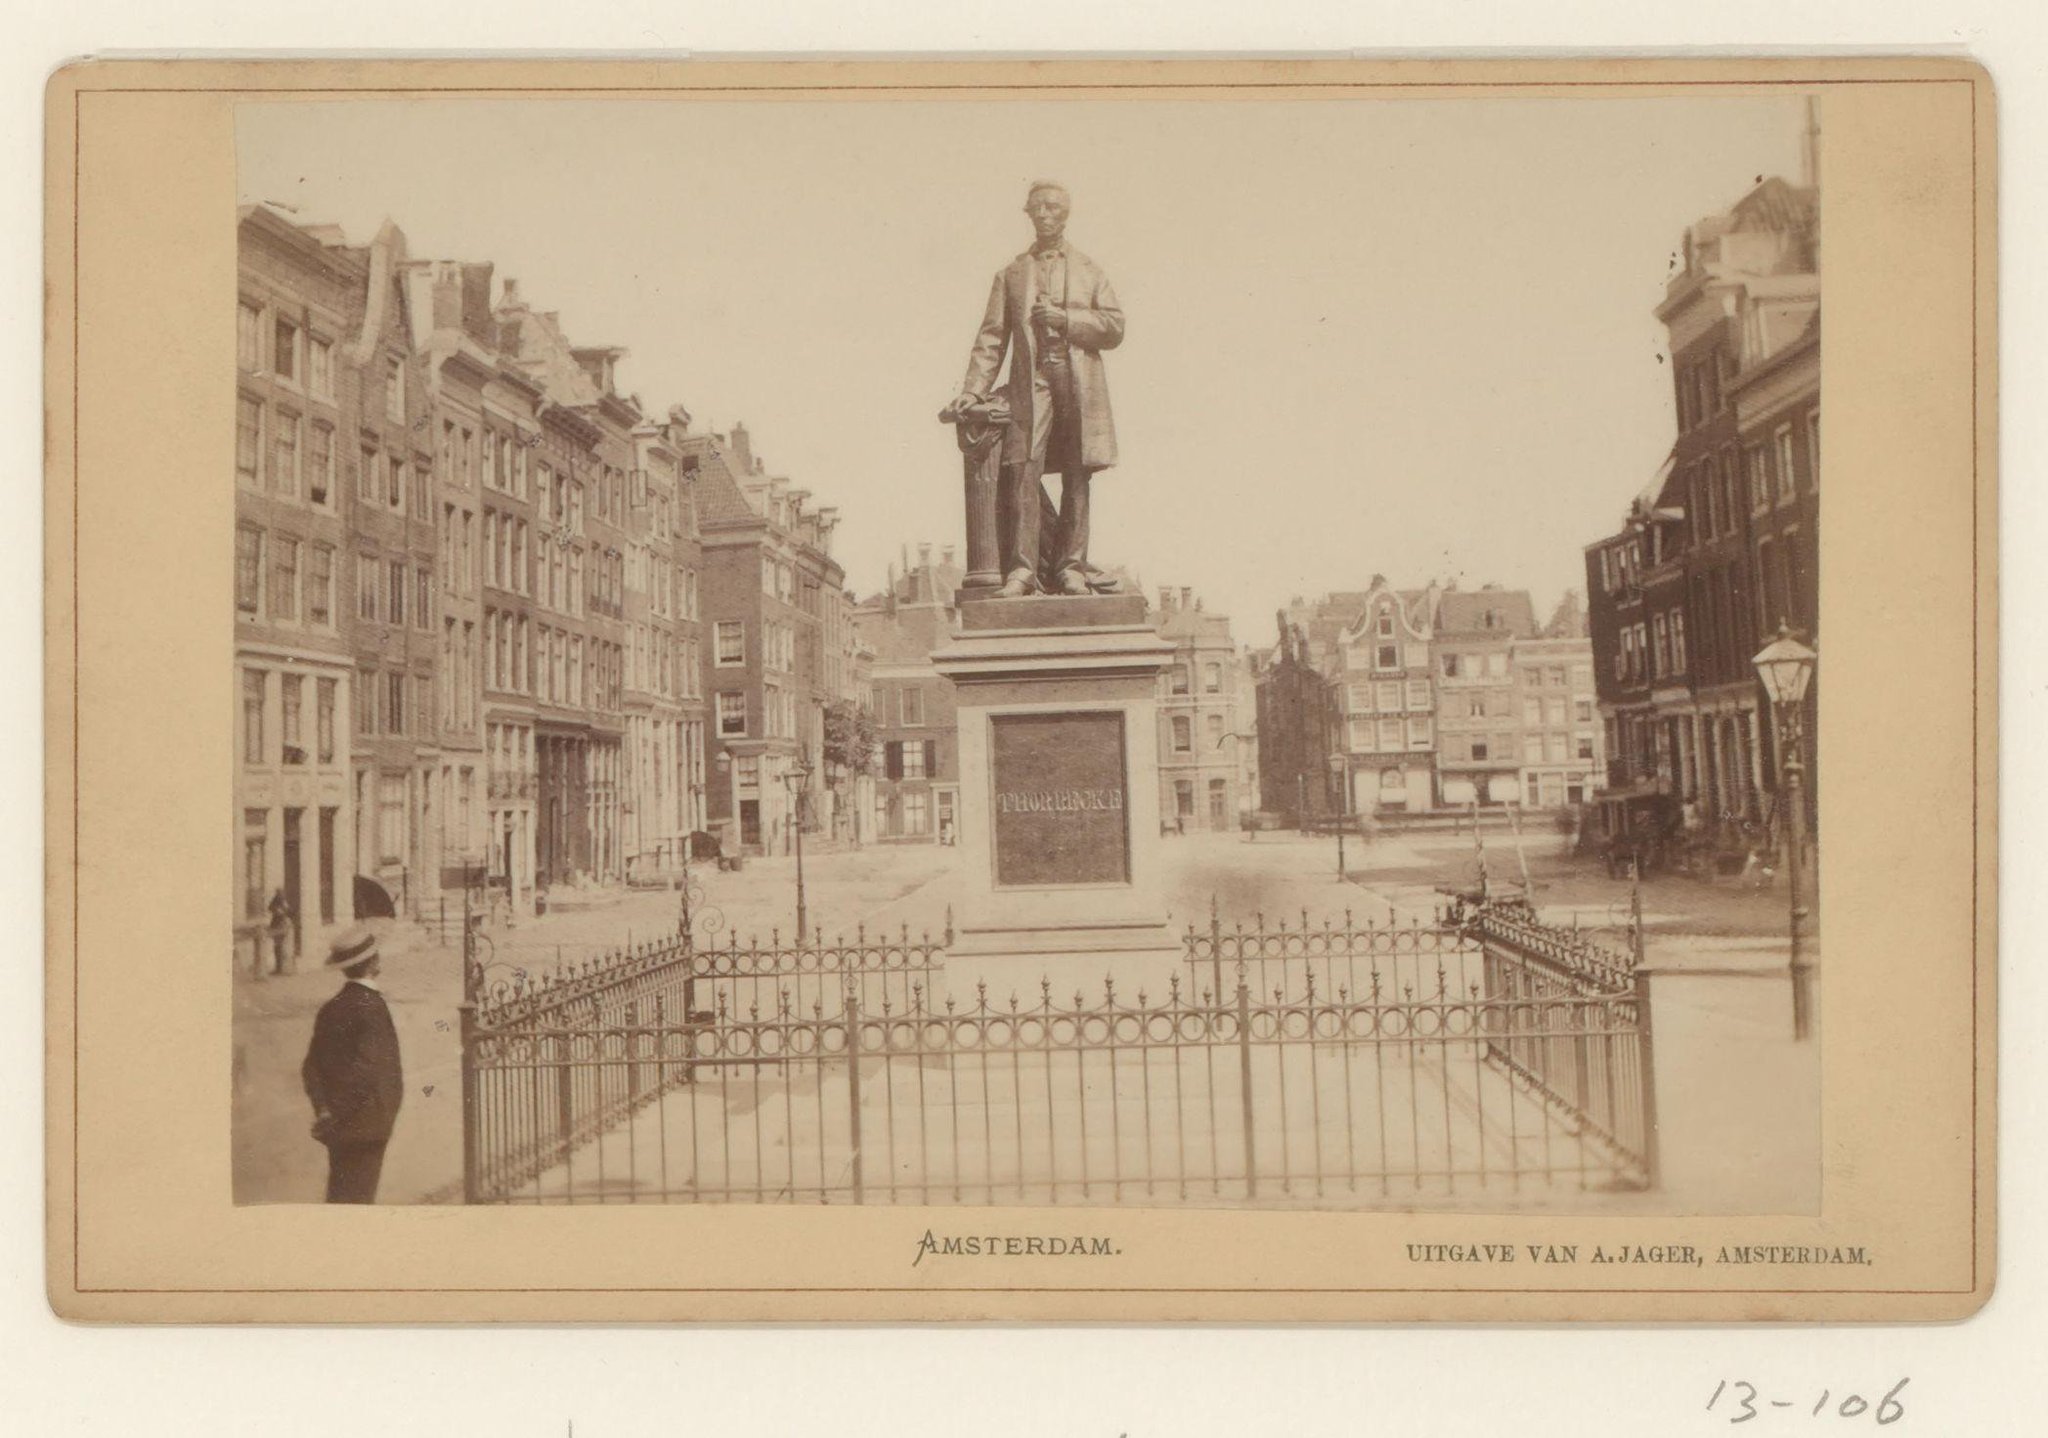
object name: cabinet photograph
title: Gezicht op het Thorbeckeplein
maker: andries jager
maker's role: publisher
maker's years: 1825-1905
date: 1876-1905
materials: cardboard, paper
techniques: albumen print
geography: amsterdam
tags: square, place, circus, etc., city-view in general; 'veduta', monument, statue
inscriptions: collector's mark: ‘13,106’ Lugt 1641b, inscription: ‘Thorbeckeplein’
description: Onderwerpsrubriek binnen de Atlas Amsterdam: Taanstraat, Teertuinen (Nieuwe), Thorbeckeplein, Tolhuis, Tuinstraat (Kromme), Turfmarkt (Oude), Uilenburgergracht, Uilenburgerstraat, Utrechtsestraat.